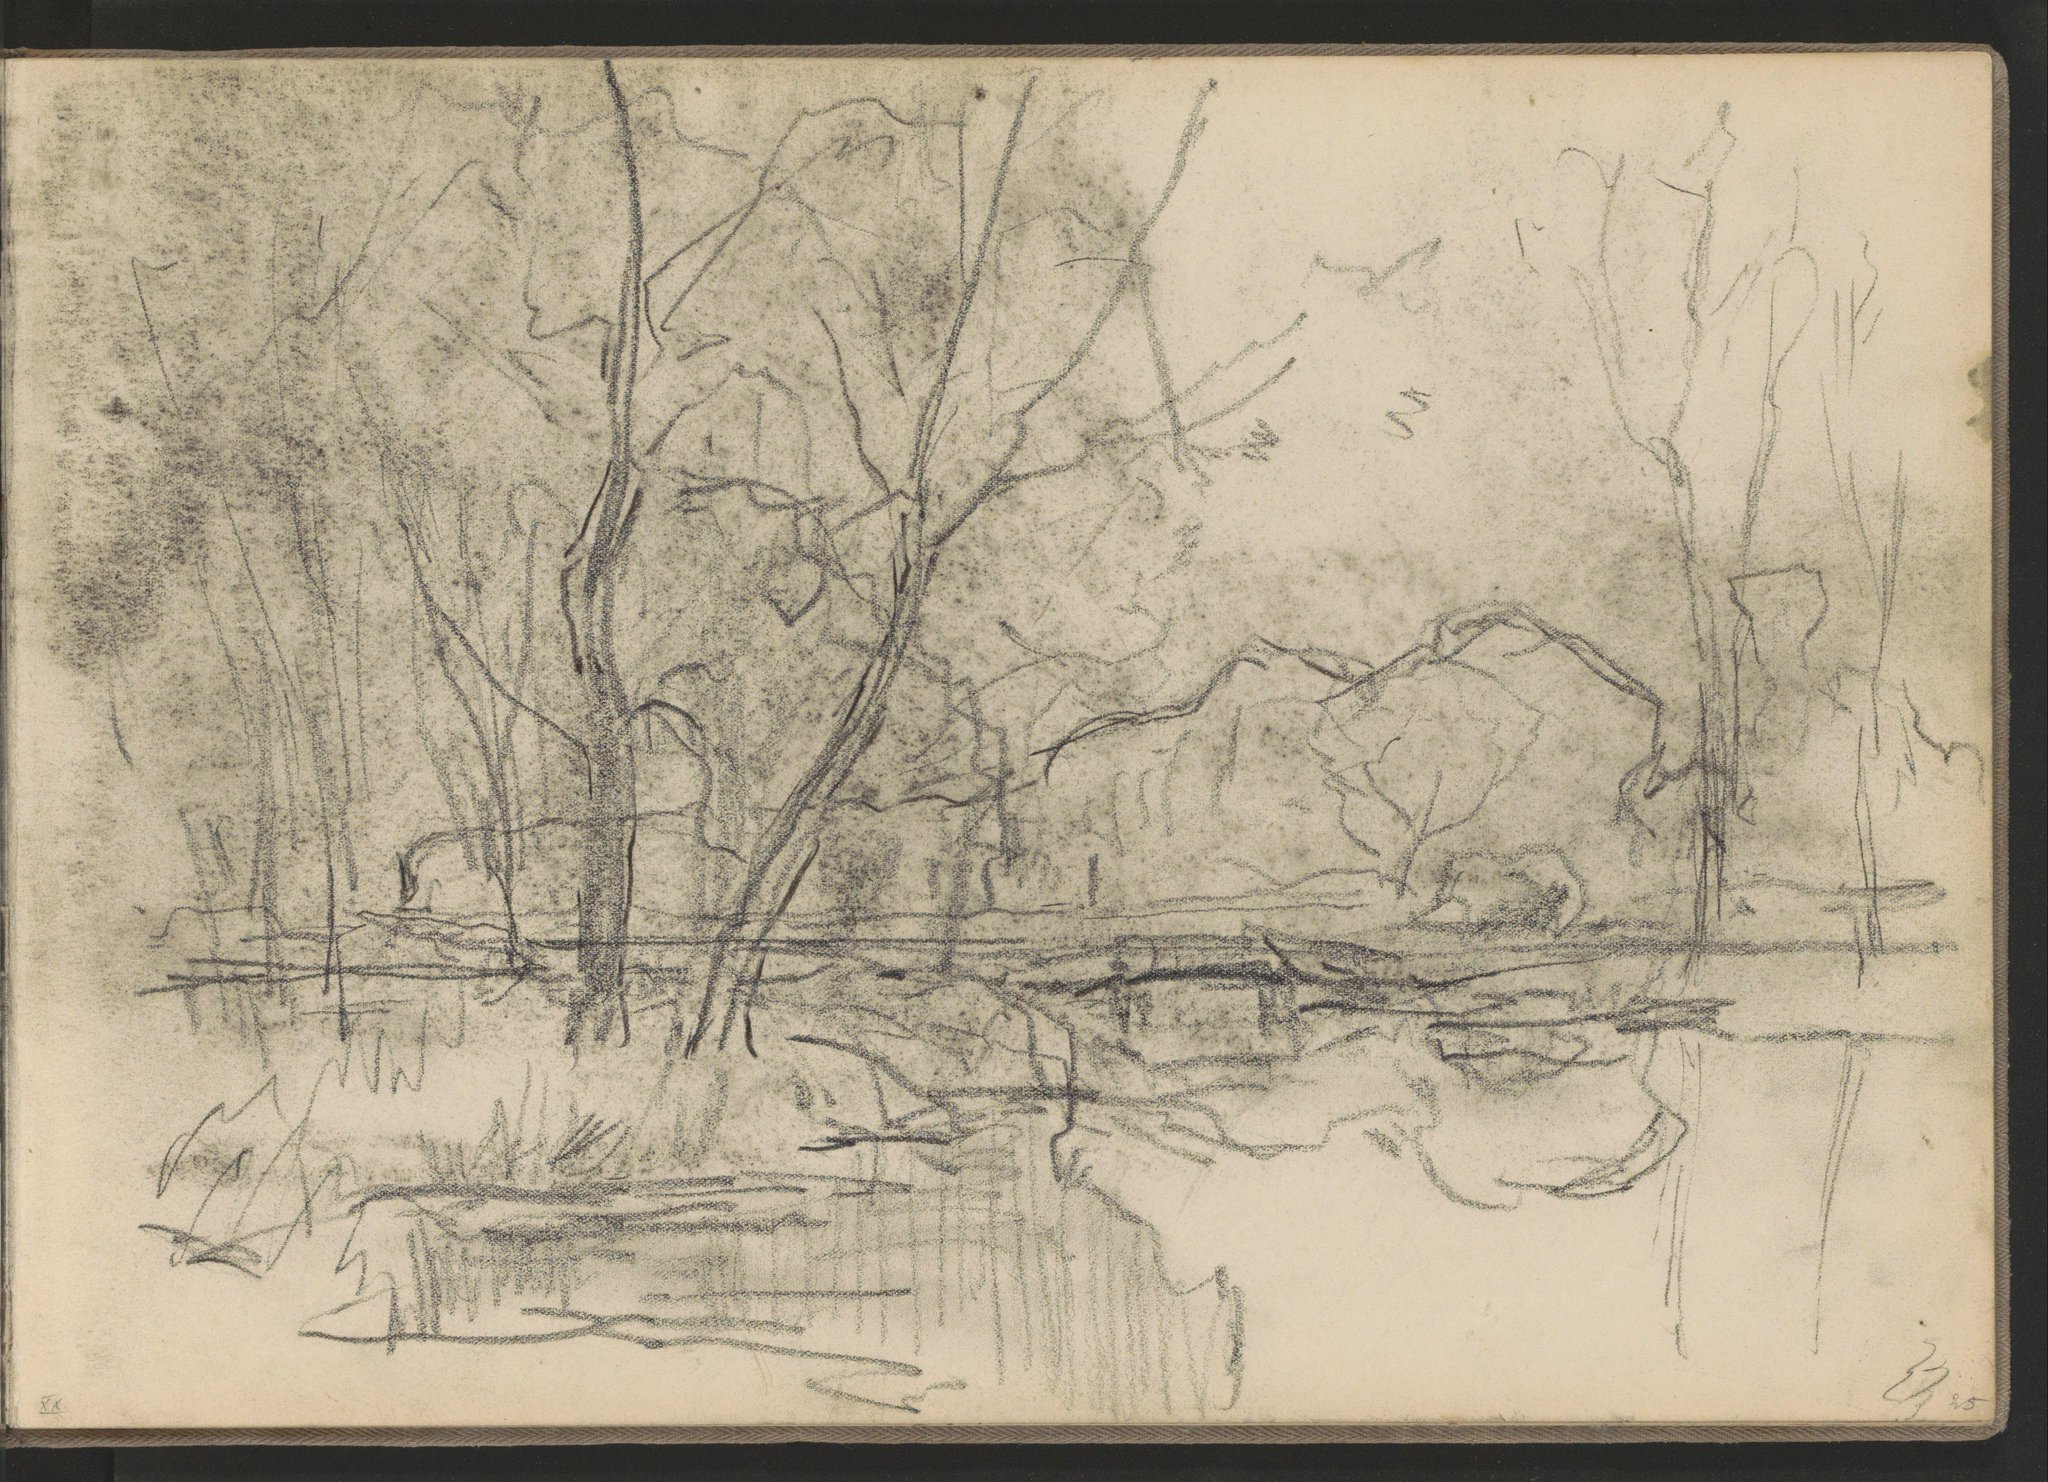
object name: sketchbook leaf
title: Landschap met brug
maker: egbert rubertus derk schaap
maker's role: draughtsman, painter, print maker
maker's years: 1862-1939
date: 1891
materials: chalk, paper, pencil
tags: landscapes with waters, waterscapes, seascapes (in the temperate zone), bridge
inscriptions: number: ‘XX’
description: Pagina 25 uit een schetsboek met 64 pagina's.